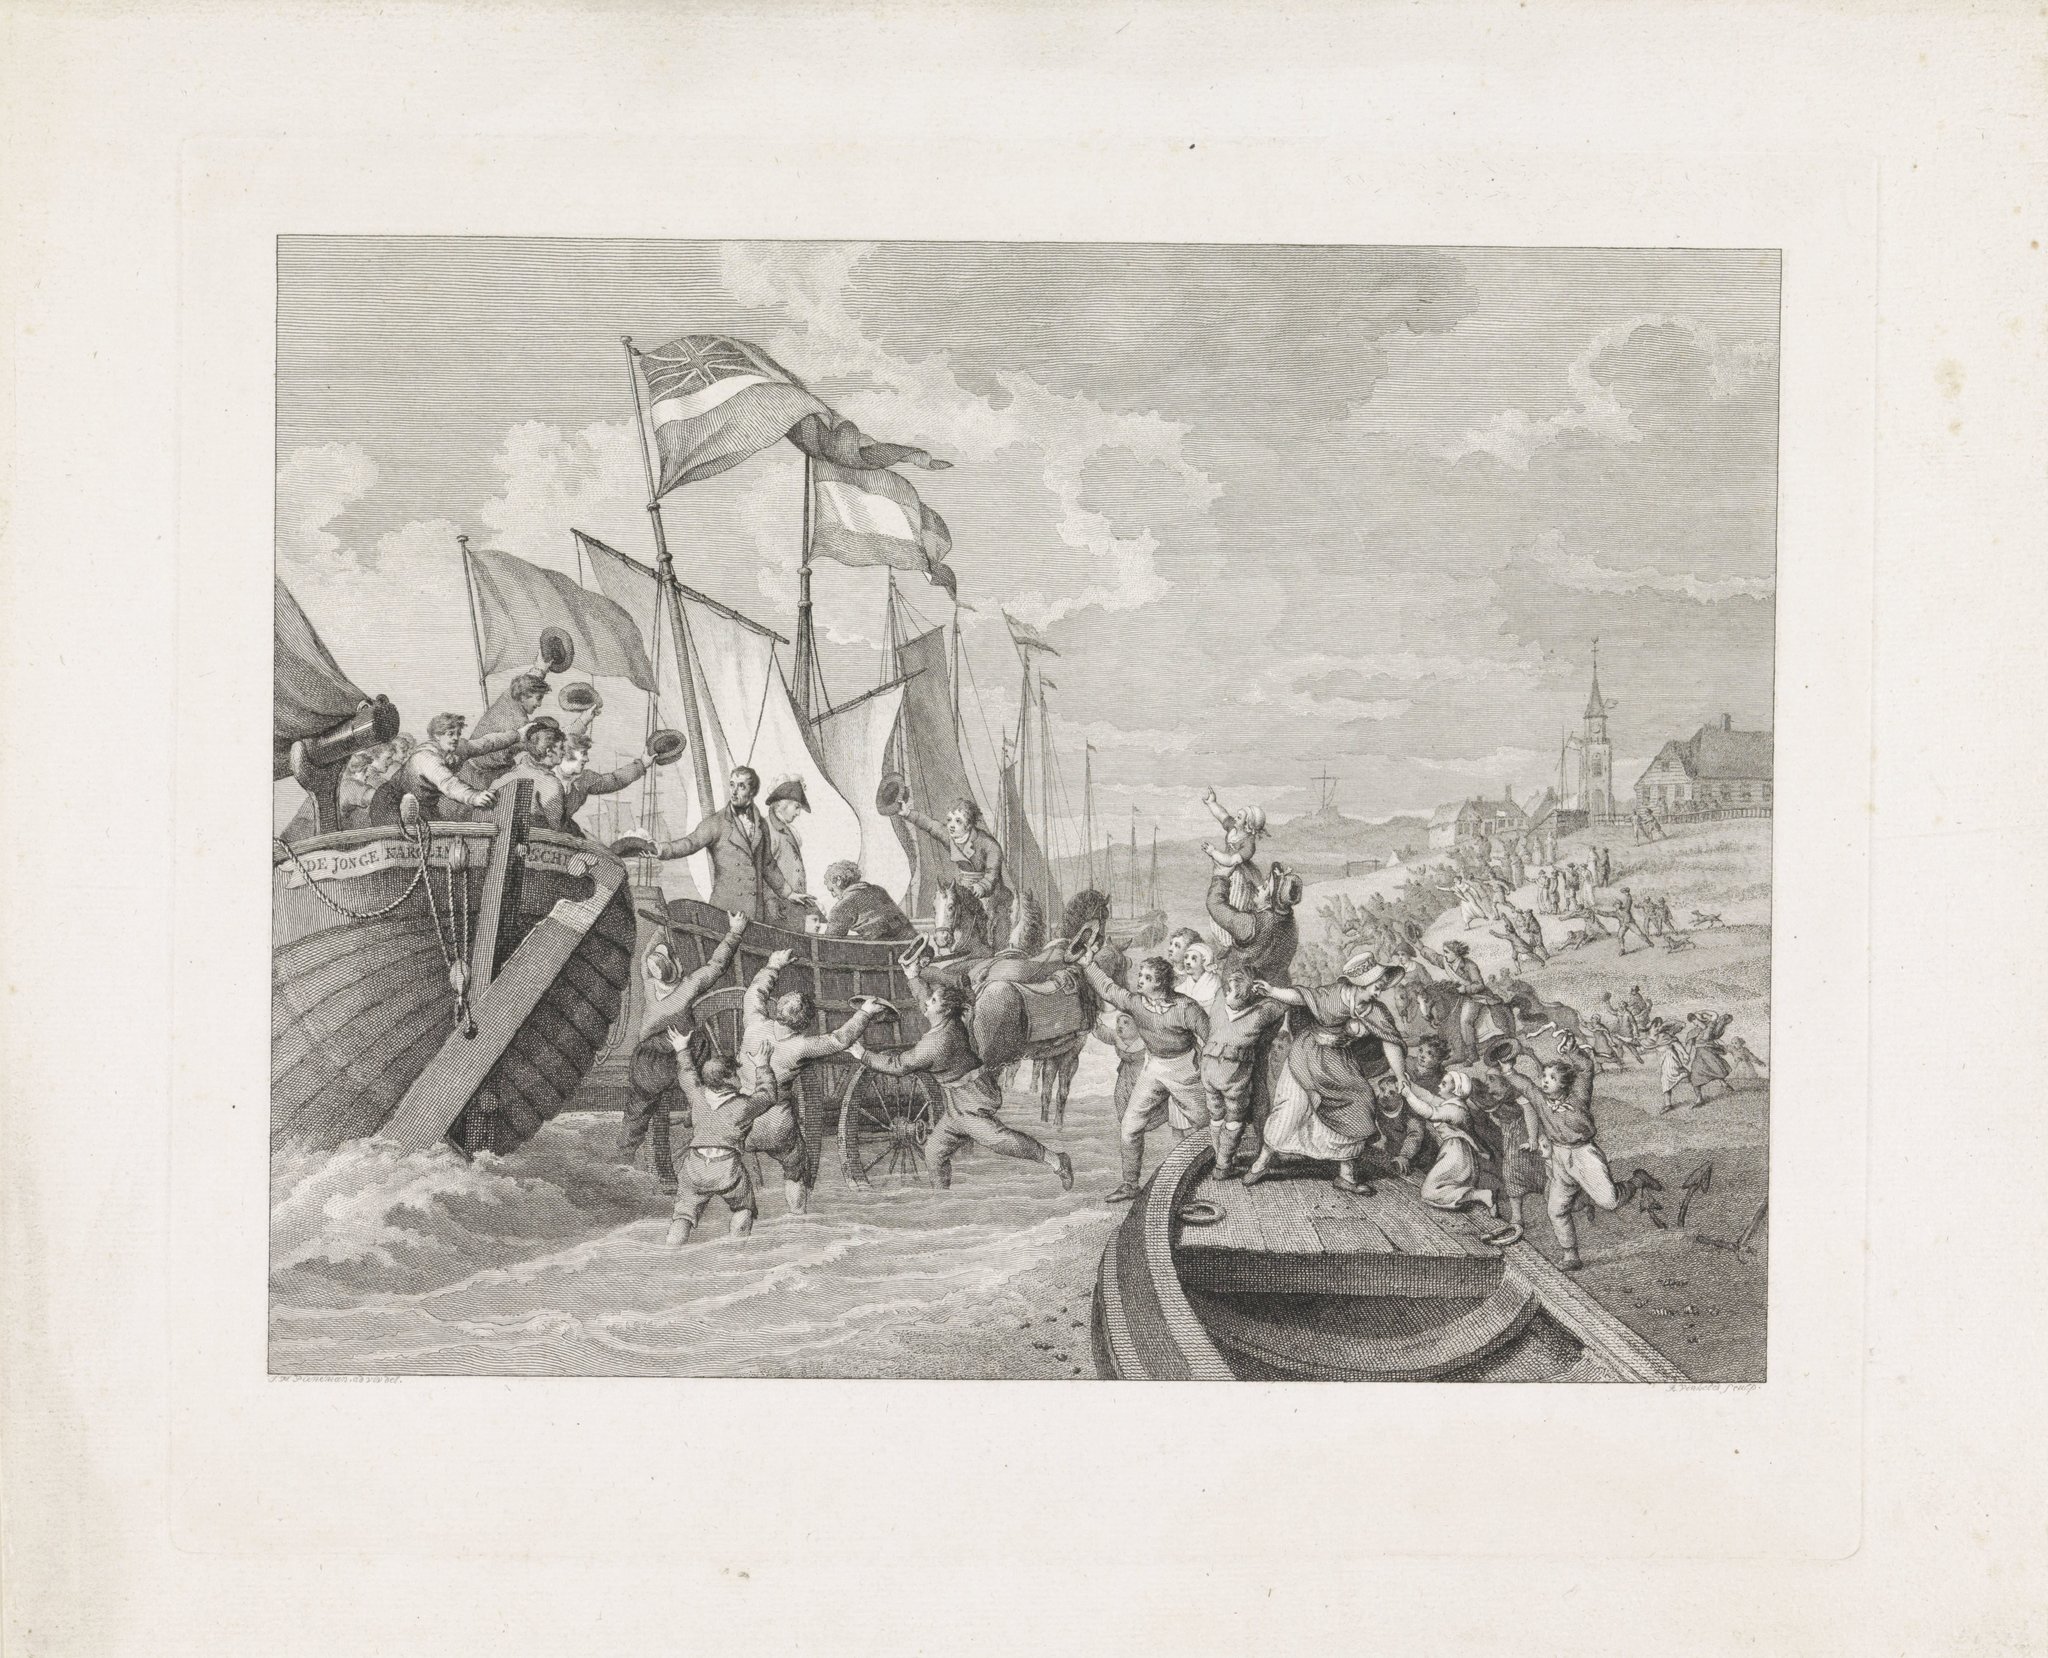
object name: print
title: Aankomst van koning Willem I te Scheveningen, 1813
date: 1813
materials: paper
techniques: engraving, etching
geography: scheveningen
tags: the hague, berlin, william i of the netherlands, being welcomed ~ travelling, homage to a ruler, landing of william frederick i (1813)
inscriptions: collector's mark: Lugt 2228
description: Aankomst van prins Willem Frederik op het strand van Scheveningen, 30 november 1813, om als soeverein vorst de regering van het land op zich te nemen. De prins staande in de boerenwagen, links de visserspink 'De Jonge Karolina' die hem naar de kust heeft gebracht. Op het strand begroet een enthousiaste menigte de prins.